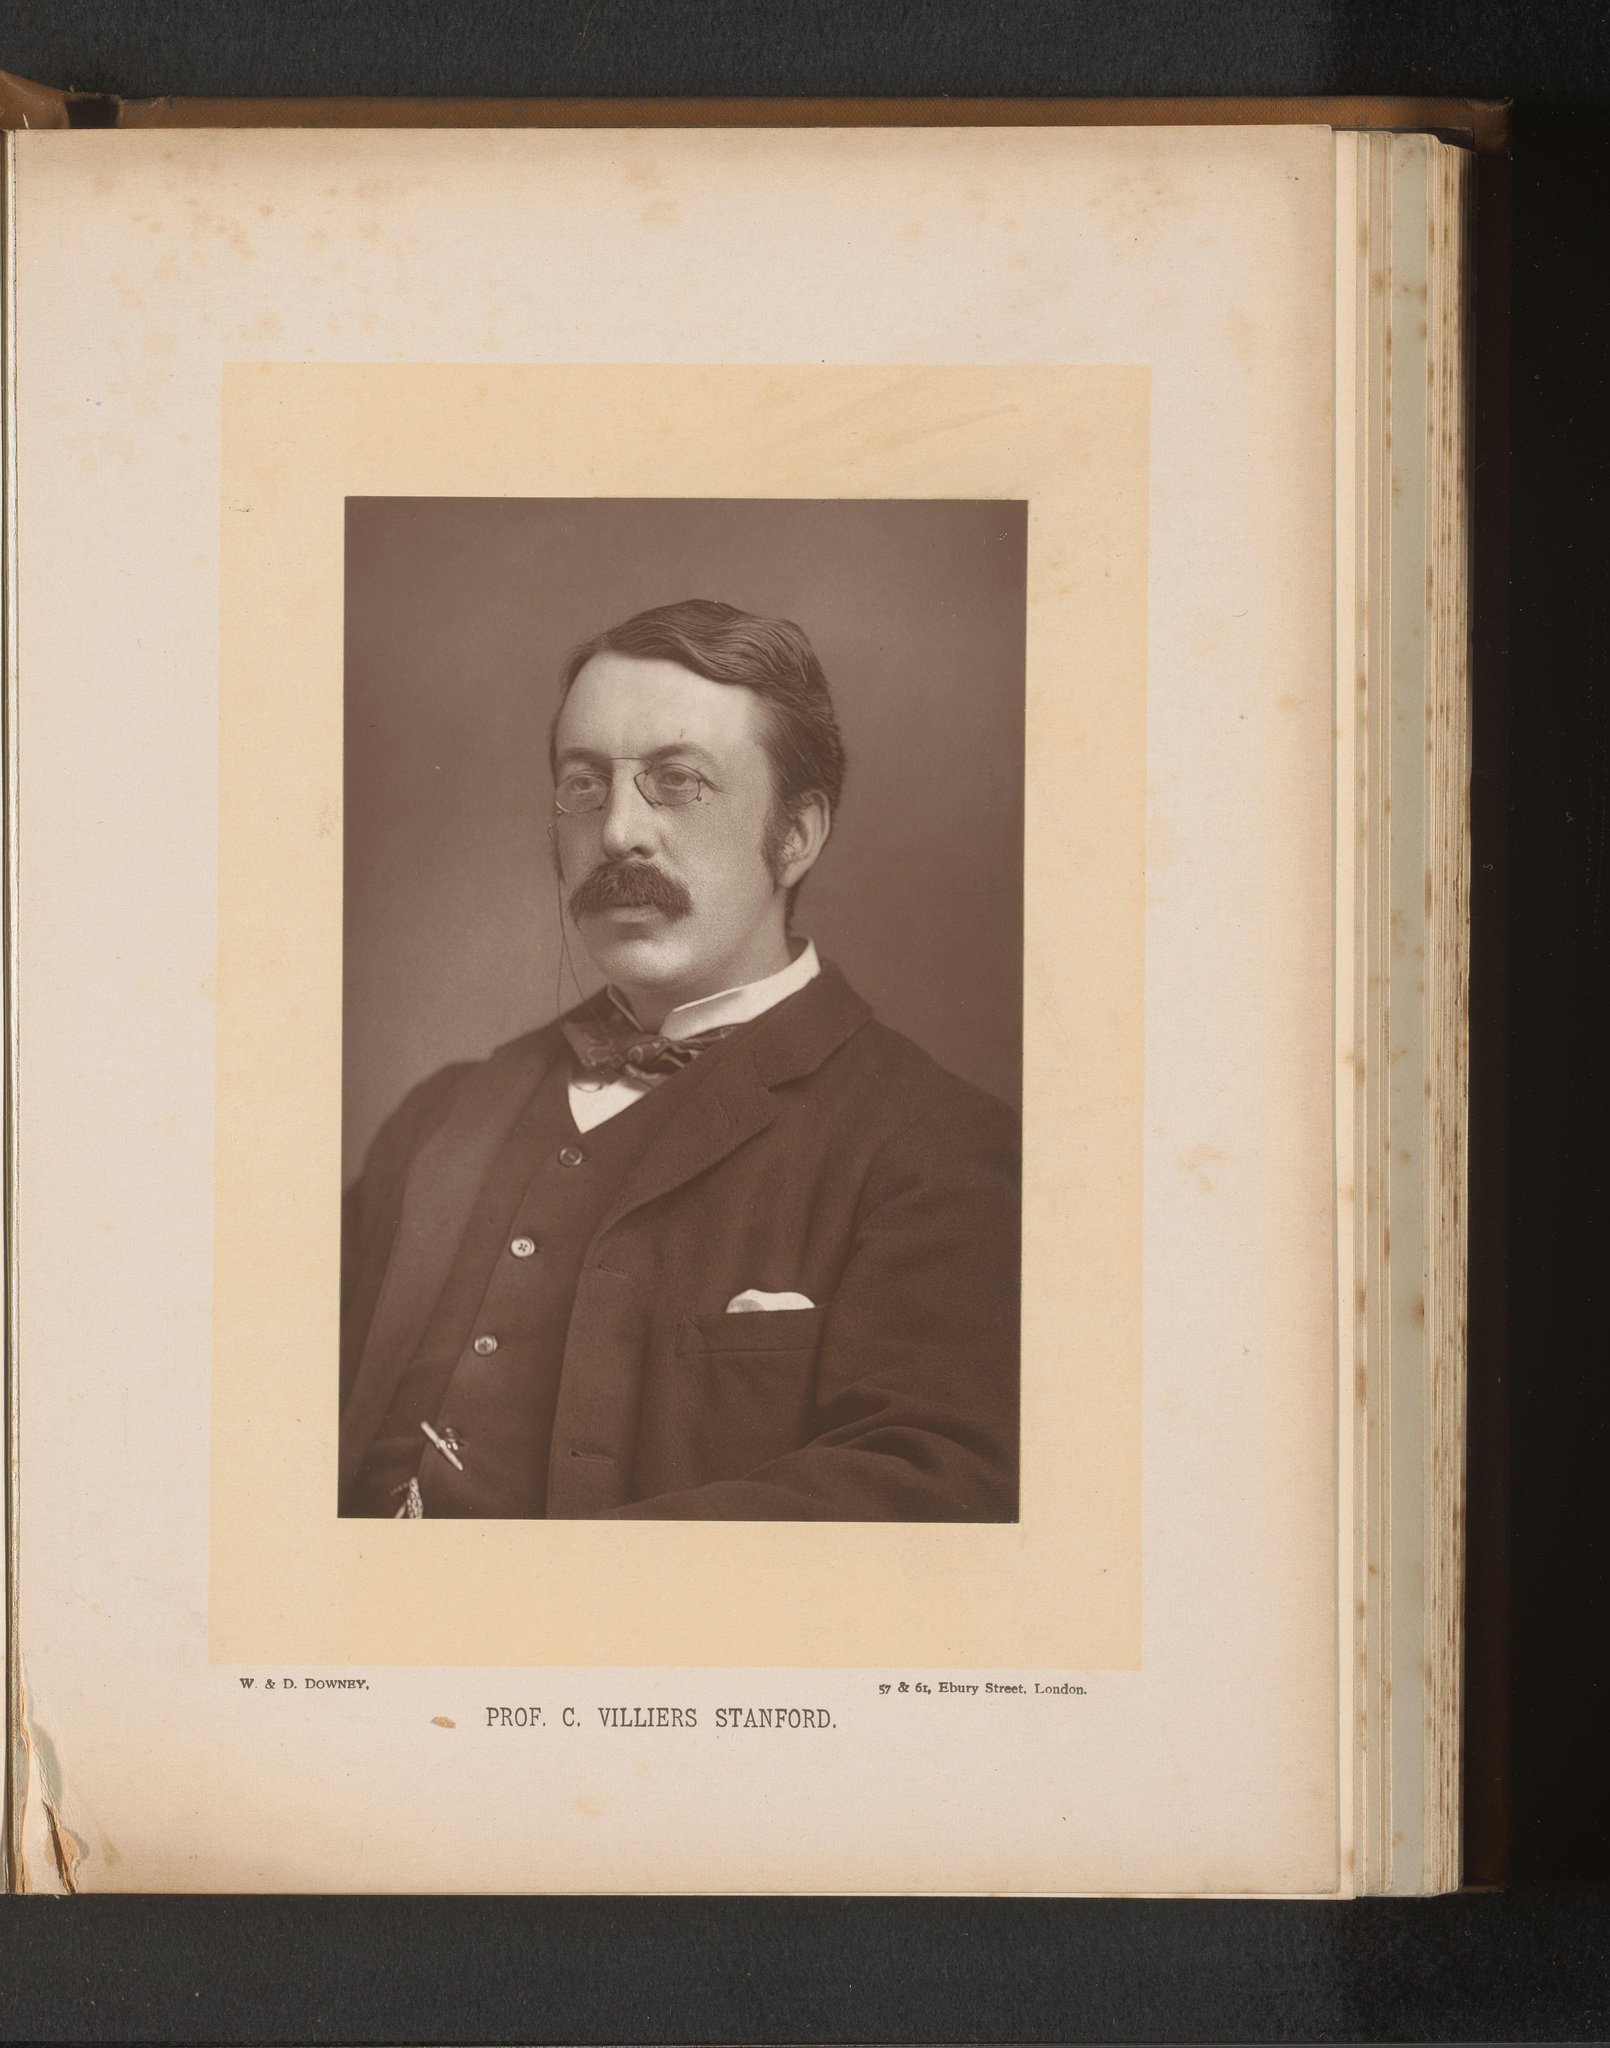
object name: page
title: Portret van Charles Villiers Stanford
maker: Anonymous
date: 1884-1894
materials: paper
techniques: woodburytype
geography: london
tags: conductor ~ music, composer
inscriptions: inscription: ‘57 & 61, Elbury Street, London.’